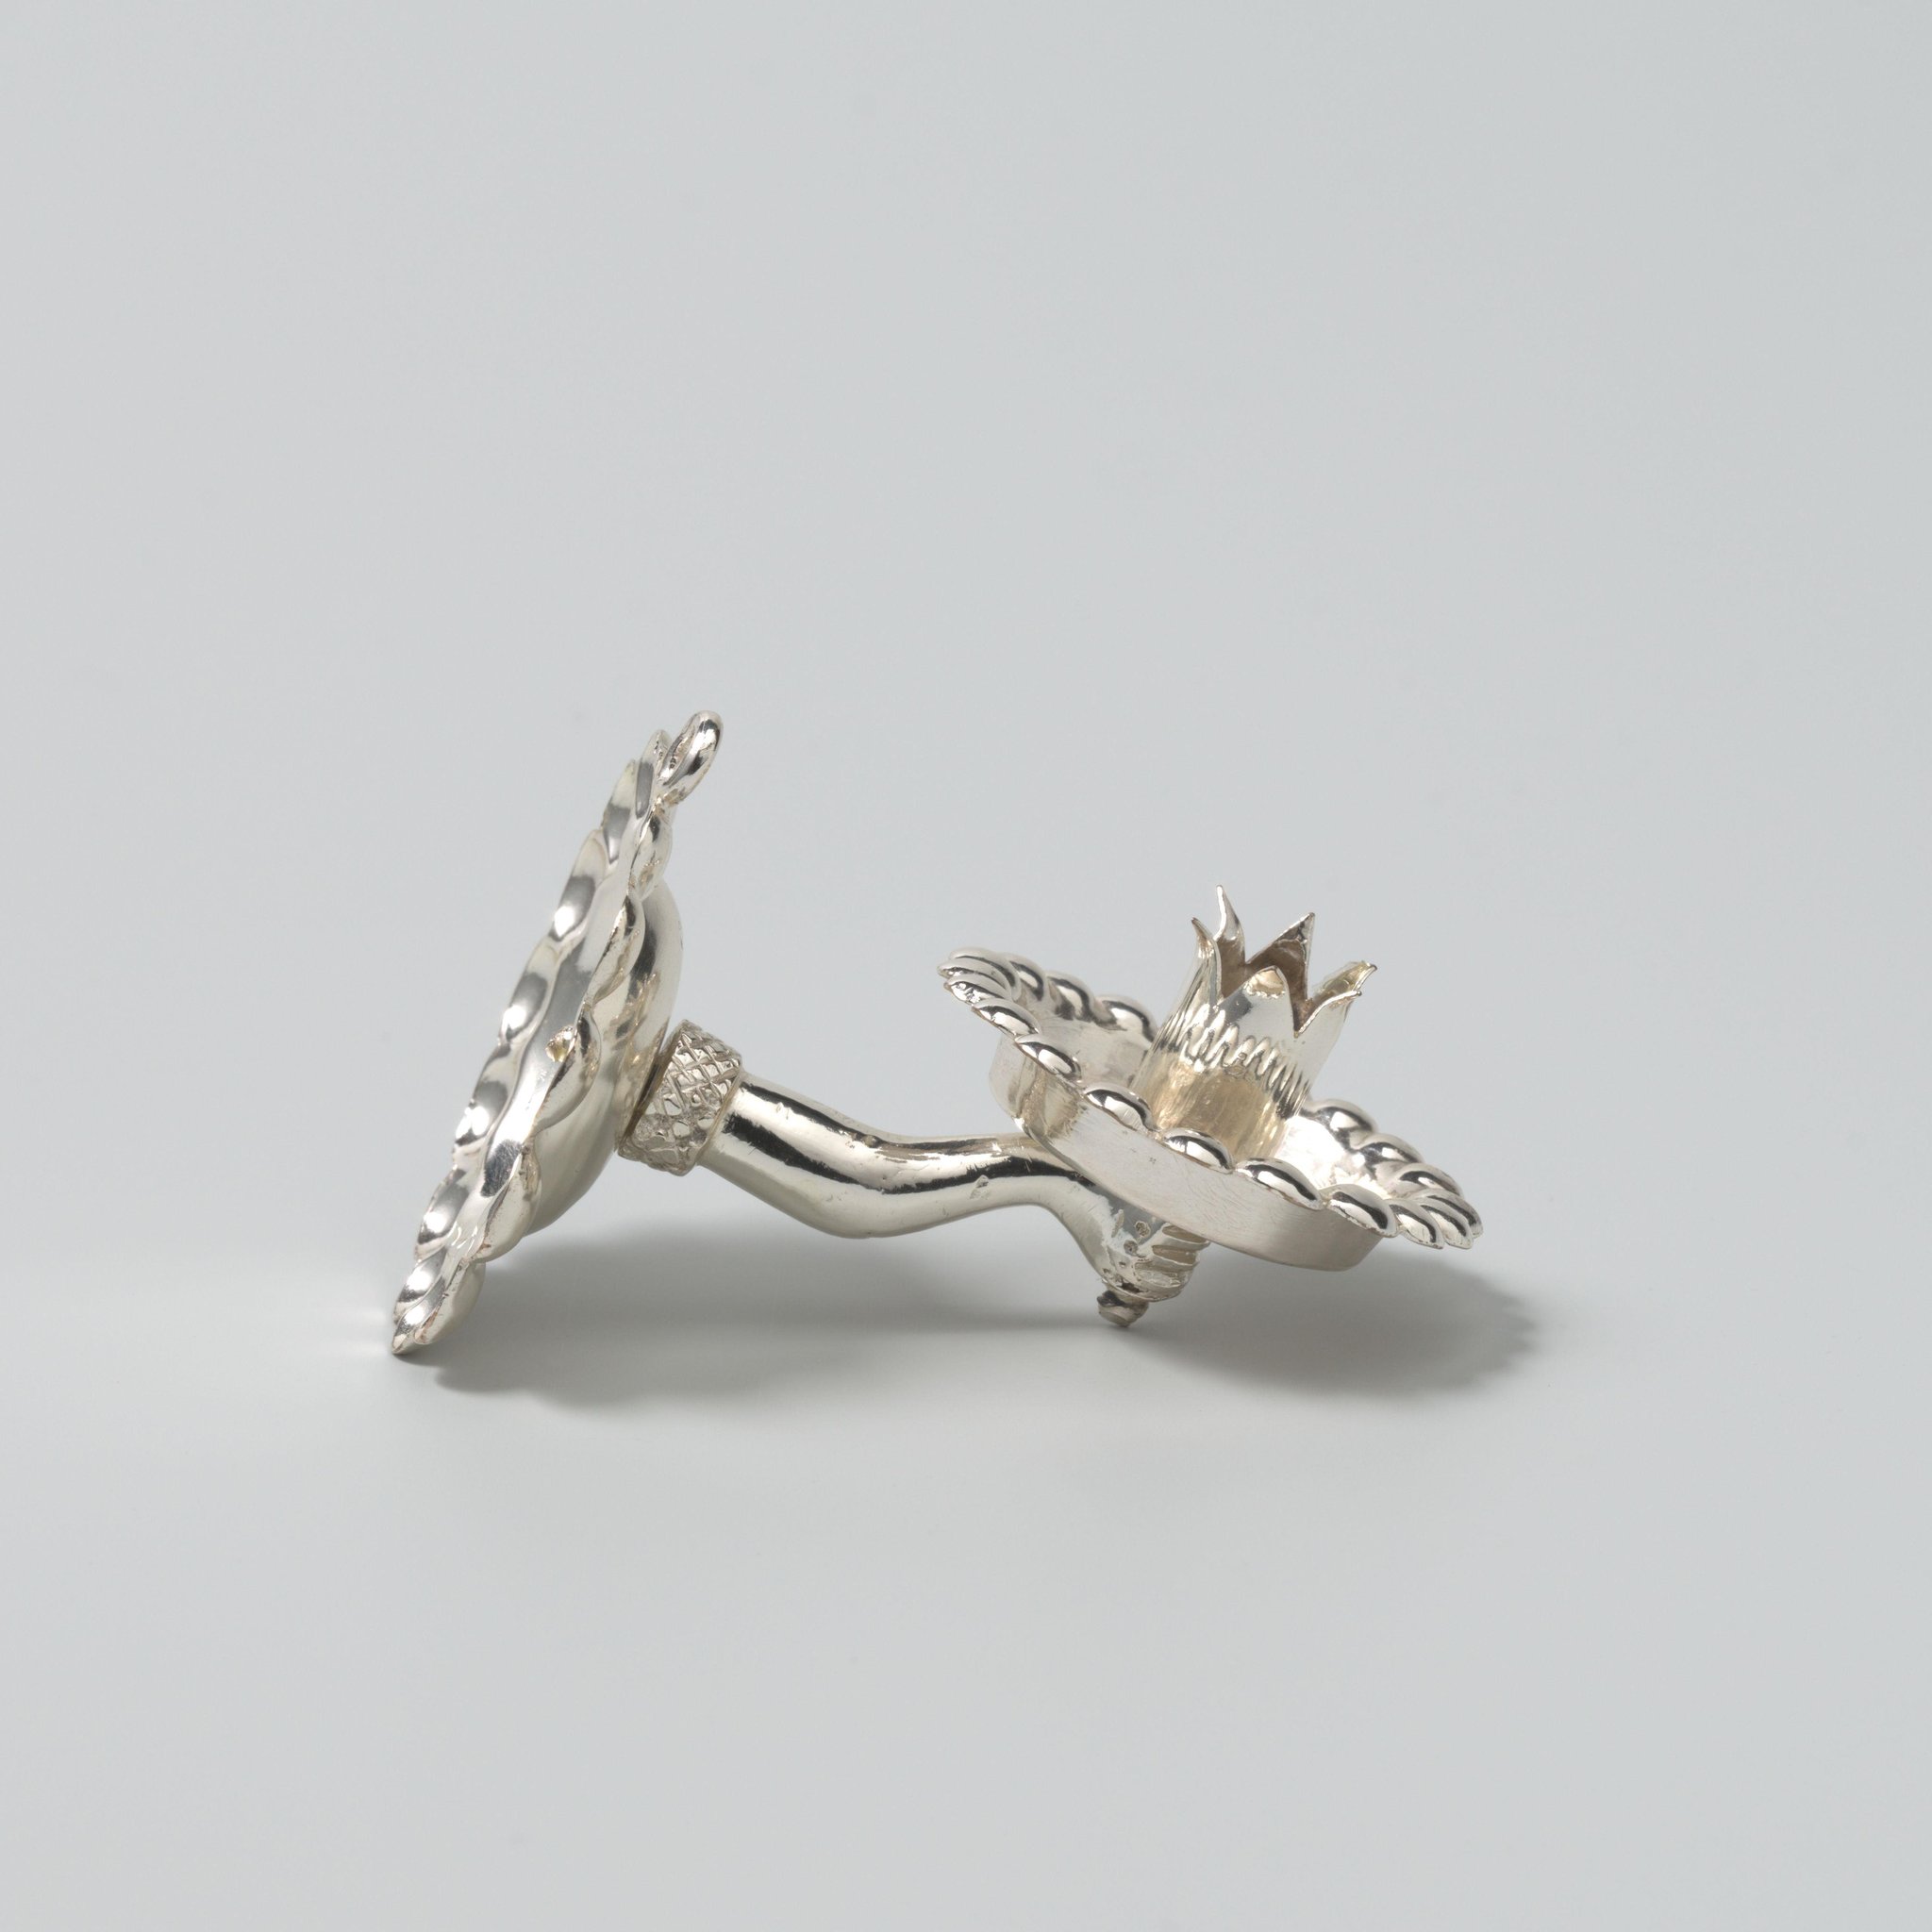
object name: miniature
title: Wandarm van zilver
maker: Anonymous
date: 1675-1725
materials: silver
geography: amsterdam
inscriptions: maker's mark: ‘gekroond klaverblad met steel in eivorm?’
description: Wandarm van zilver, bestaande uit rond wandschild met veertien lobben, waaruit een arm met hand steekt, bevestigd met schroefdraad en moer, in de hand is een vetvanger geschroeft met geschulpte rand van twintig lobben en in punten uitlopende kaarsenhouder.